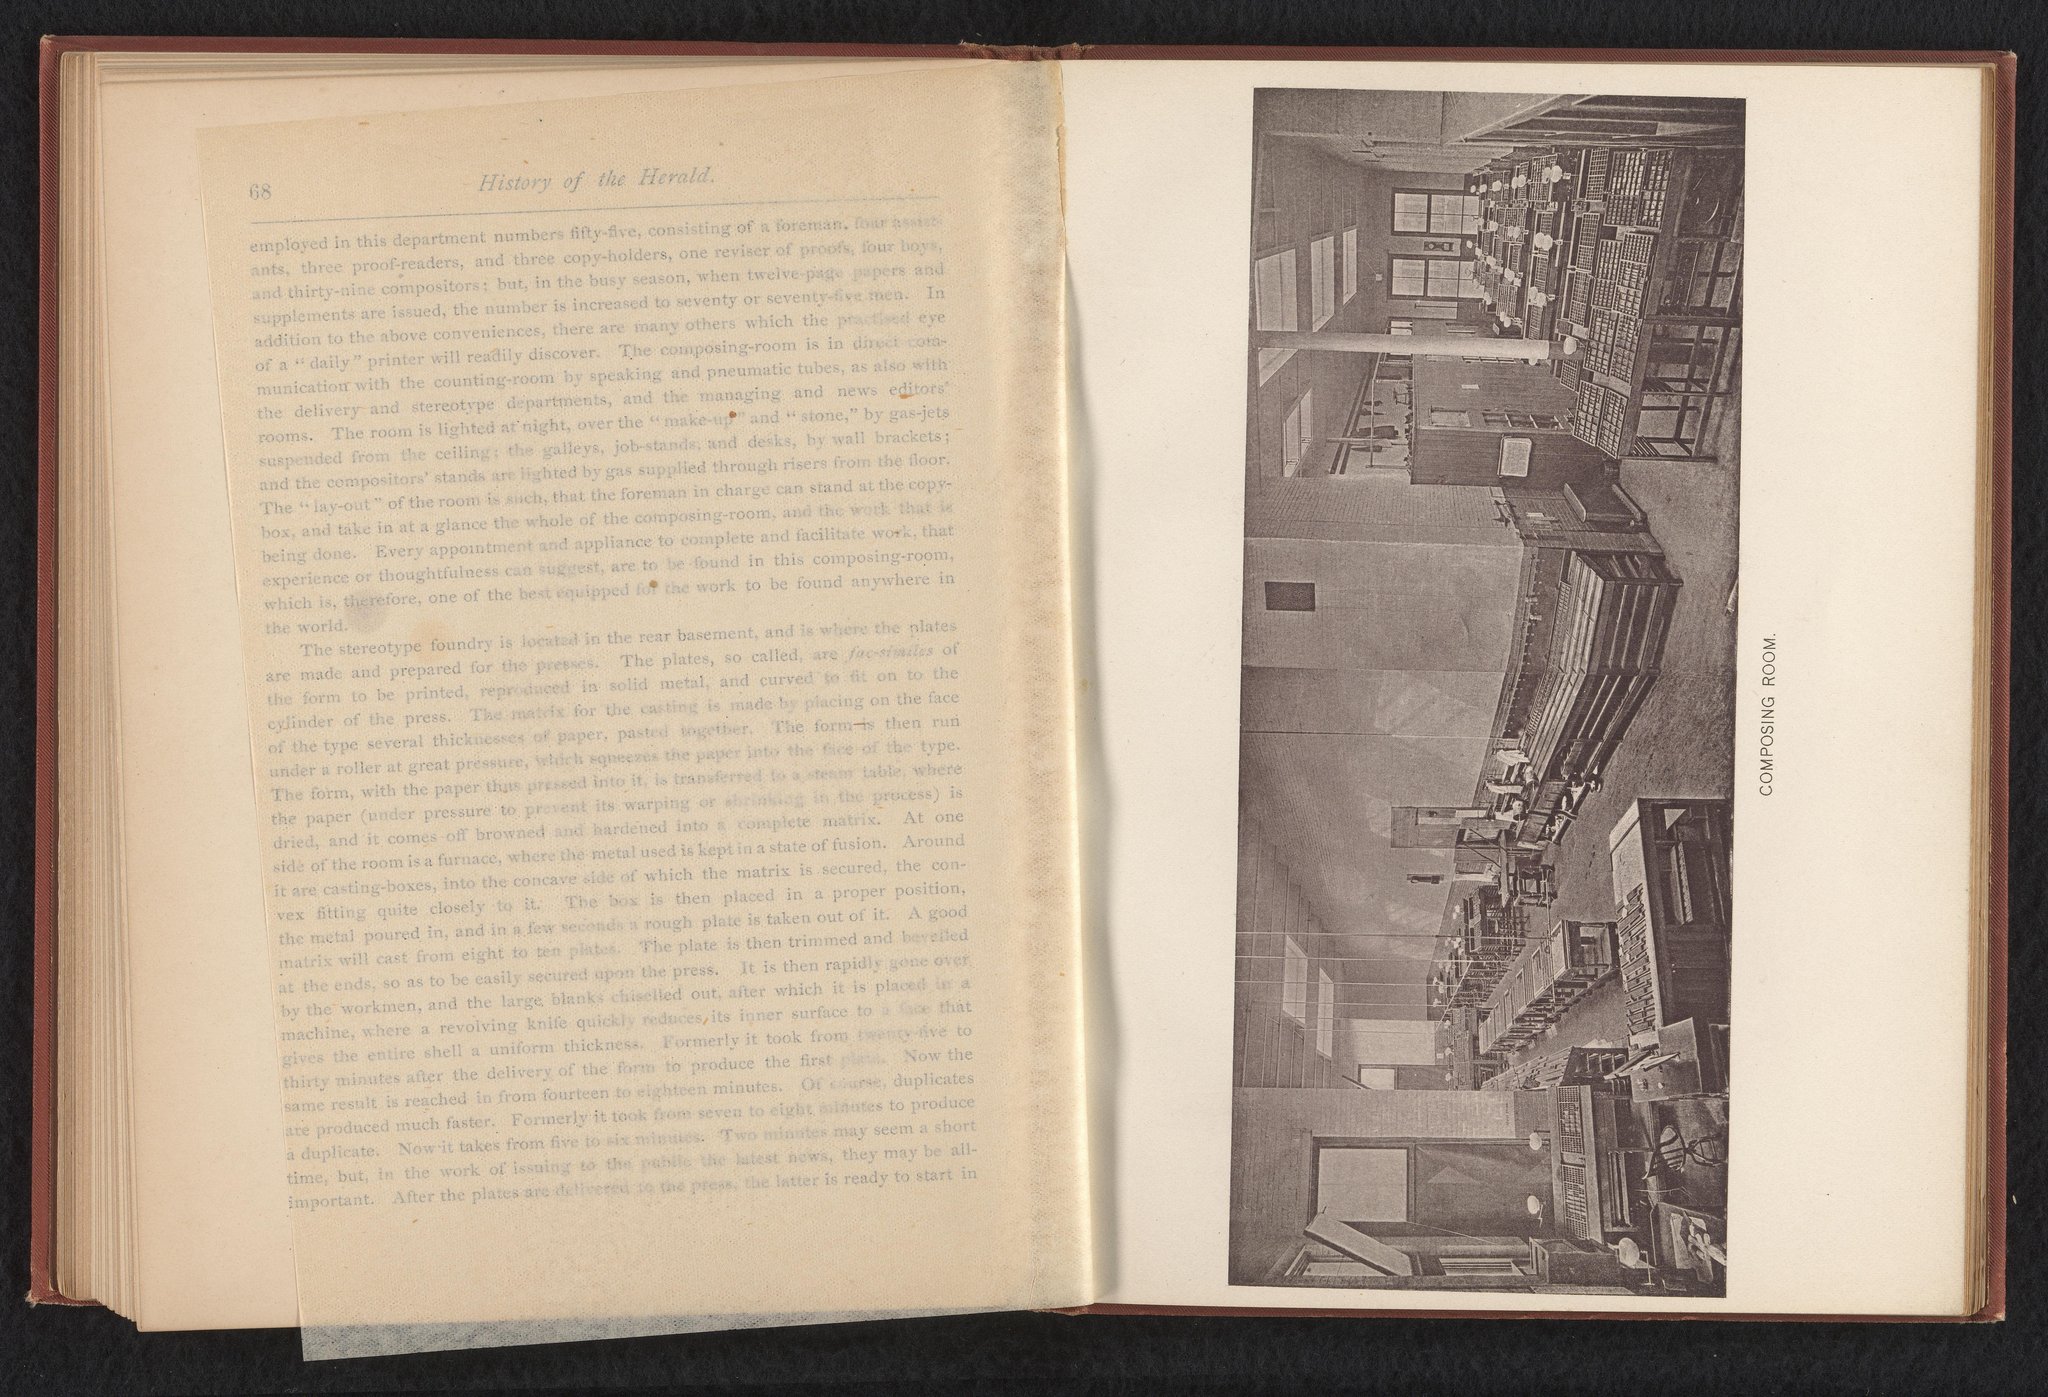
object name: photomechanical print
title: Composing Room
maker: Anonymous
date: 1873-1878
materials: paper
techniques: photograph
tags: printing, printing office, other rooms